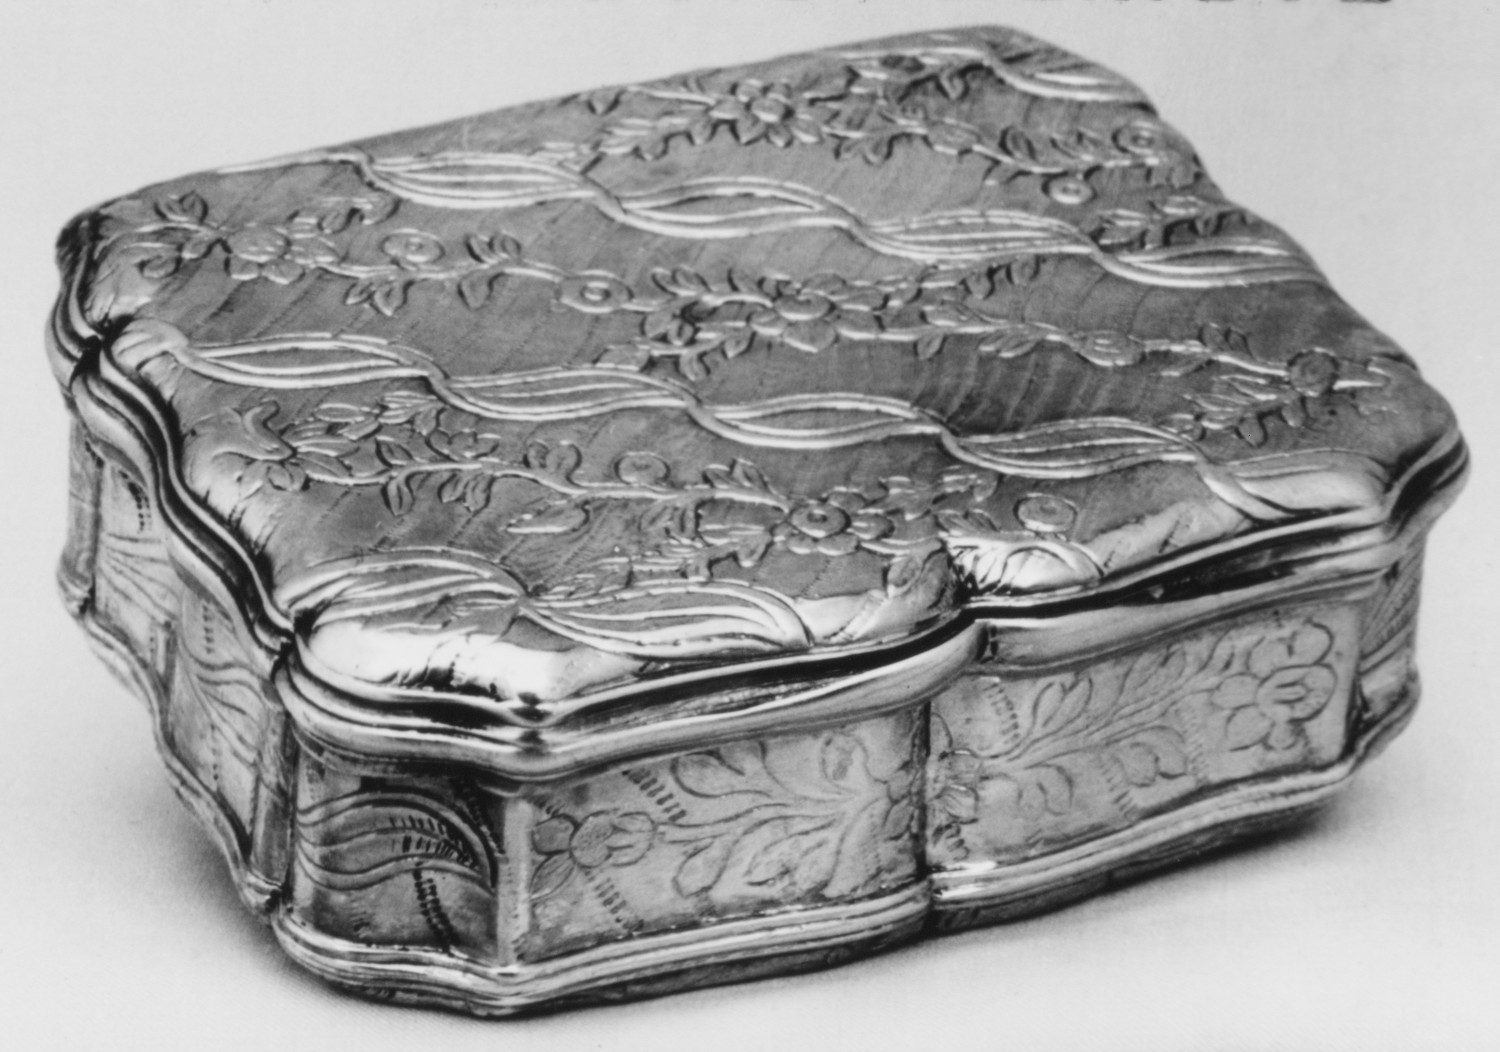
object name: snuffbox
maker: antoine daroux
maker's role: maker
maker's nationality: french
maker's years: 1689-1789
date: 1745-1746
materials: gilt, silver